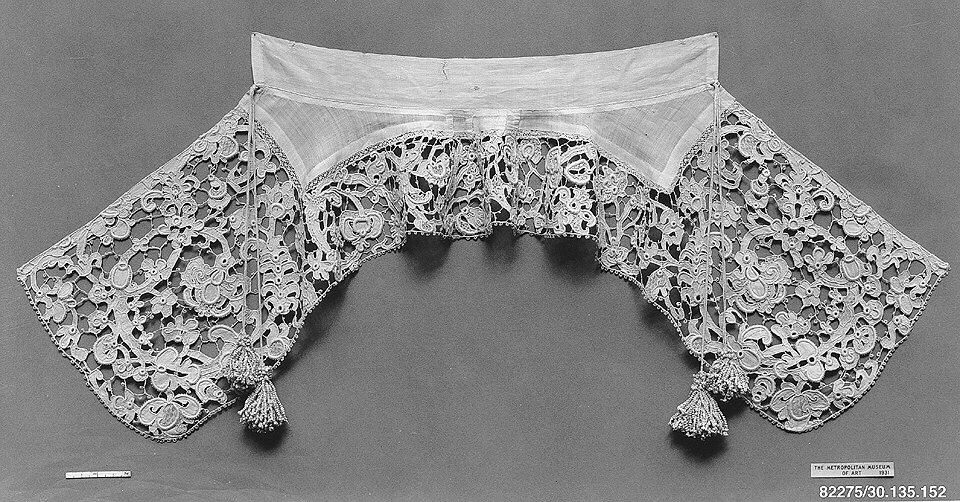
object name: collar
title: Falling band (collar) with tassels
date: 1660-1665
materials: linen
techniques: lace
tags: flowers